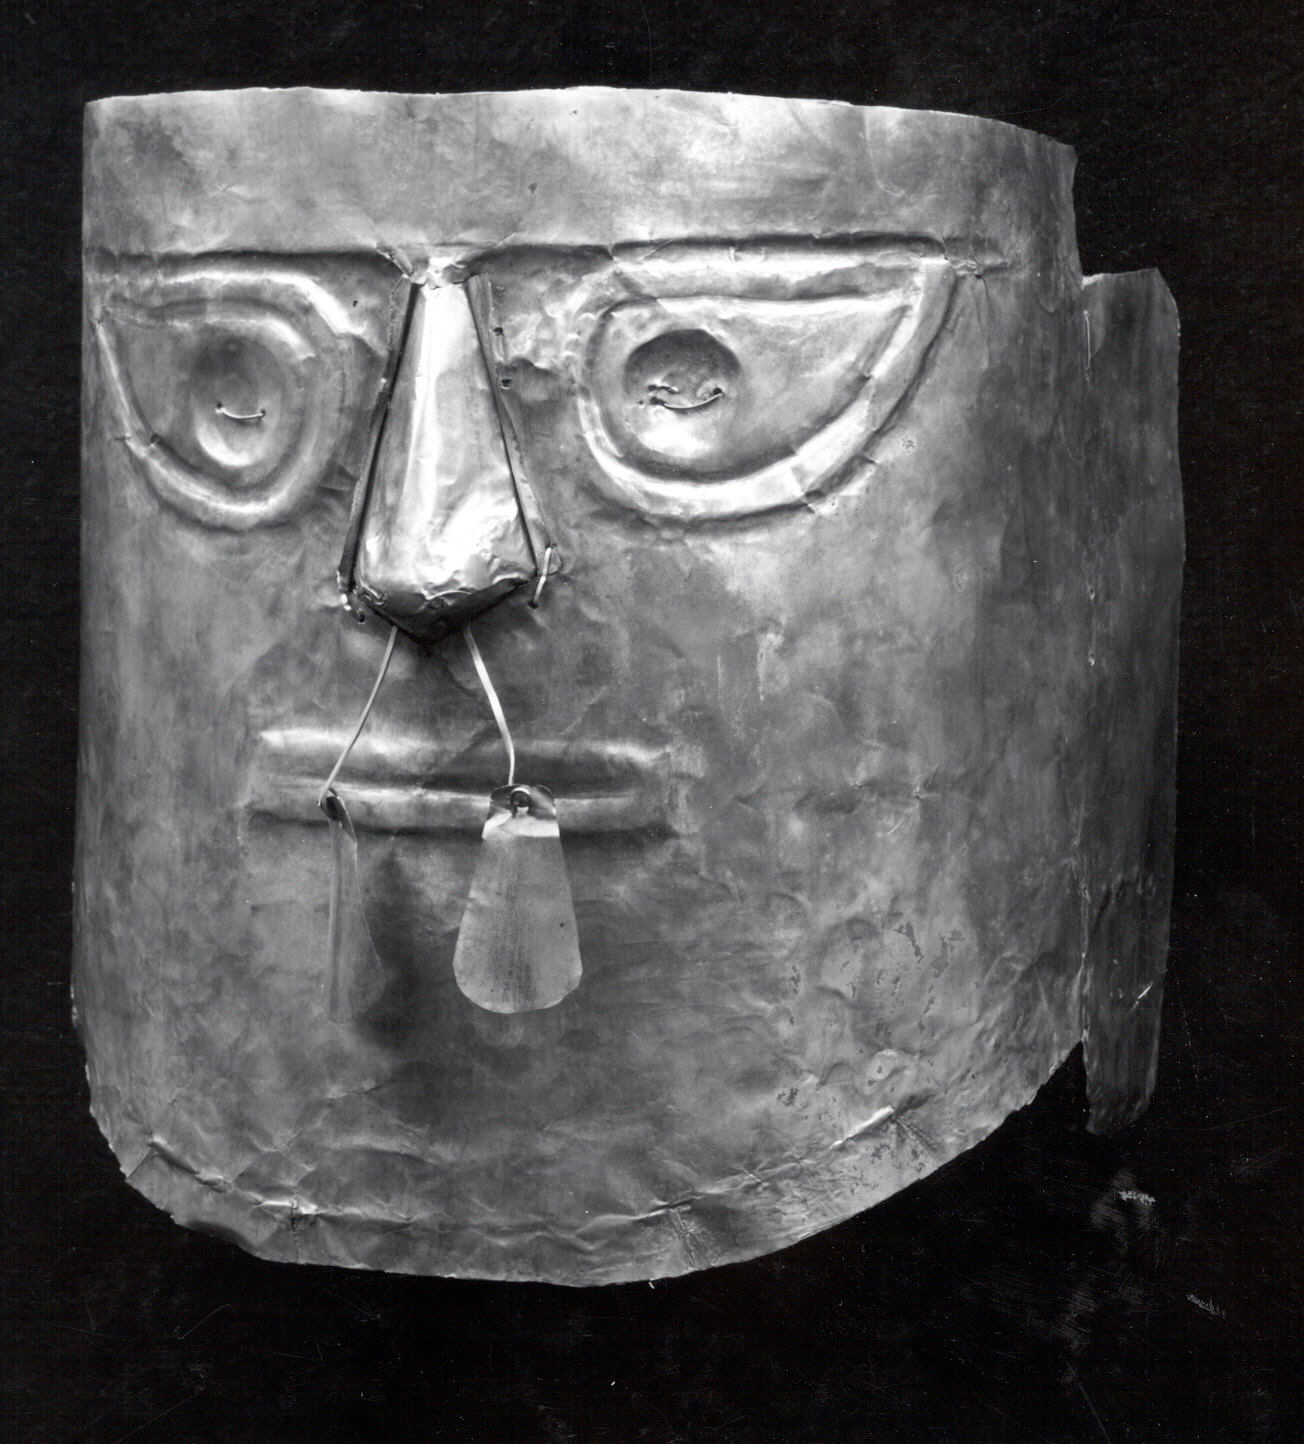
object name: mask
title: Gold Funerary Mask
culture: lambayeque, sicán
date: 801-1100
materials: gold, pigment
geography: peru